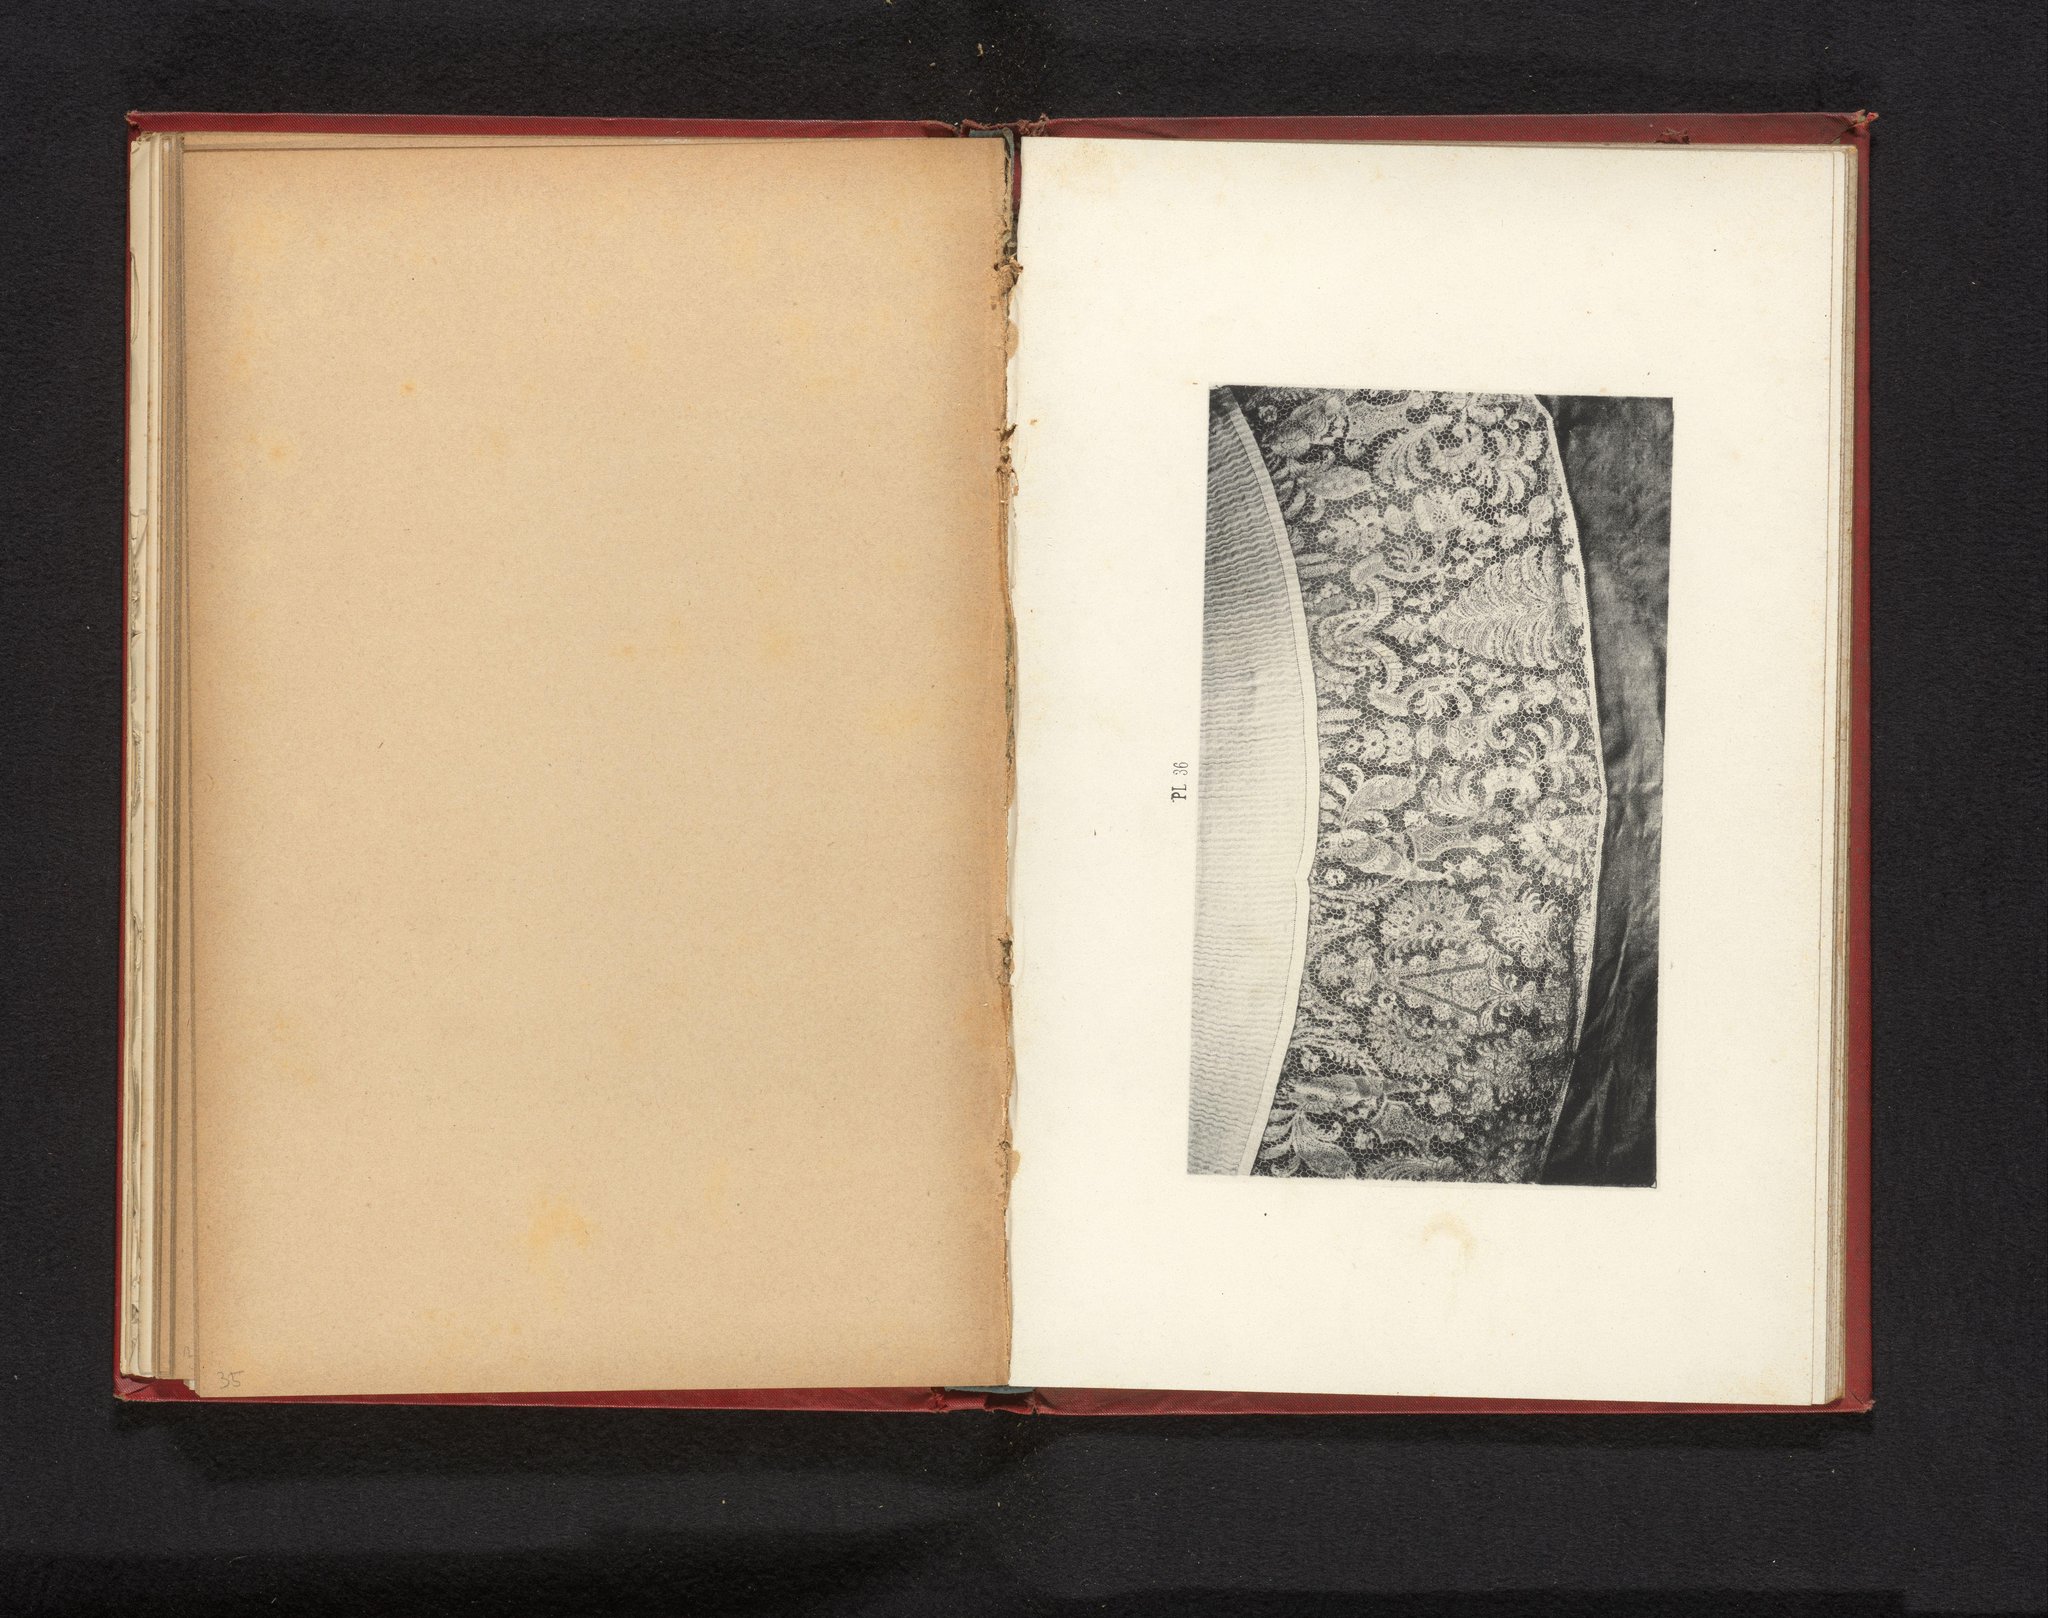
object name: page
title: Kant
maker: Anonymous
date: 1880-1881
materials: paper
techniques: photograph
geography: barcelona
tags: lace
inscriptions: number: ‘Pl 36’